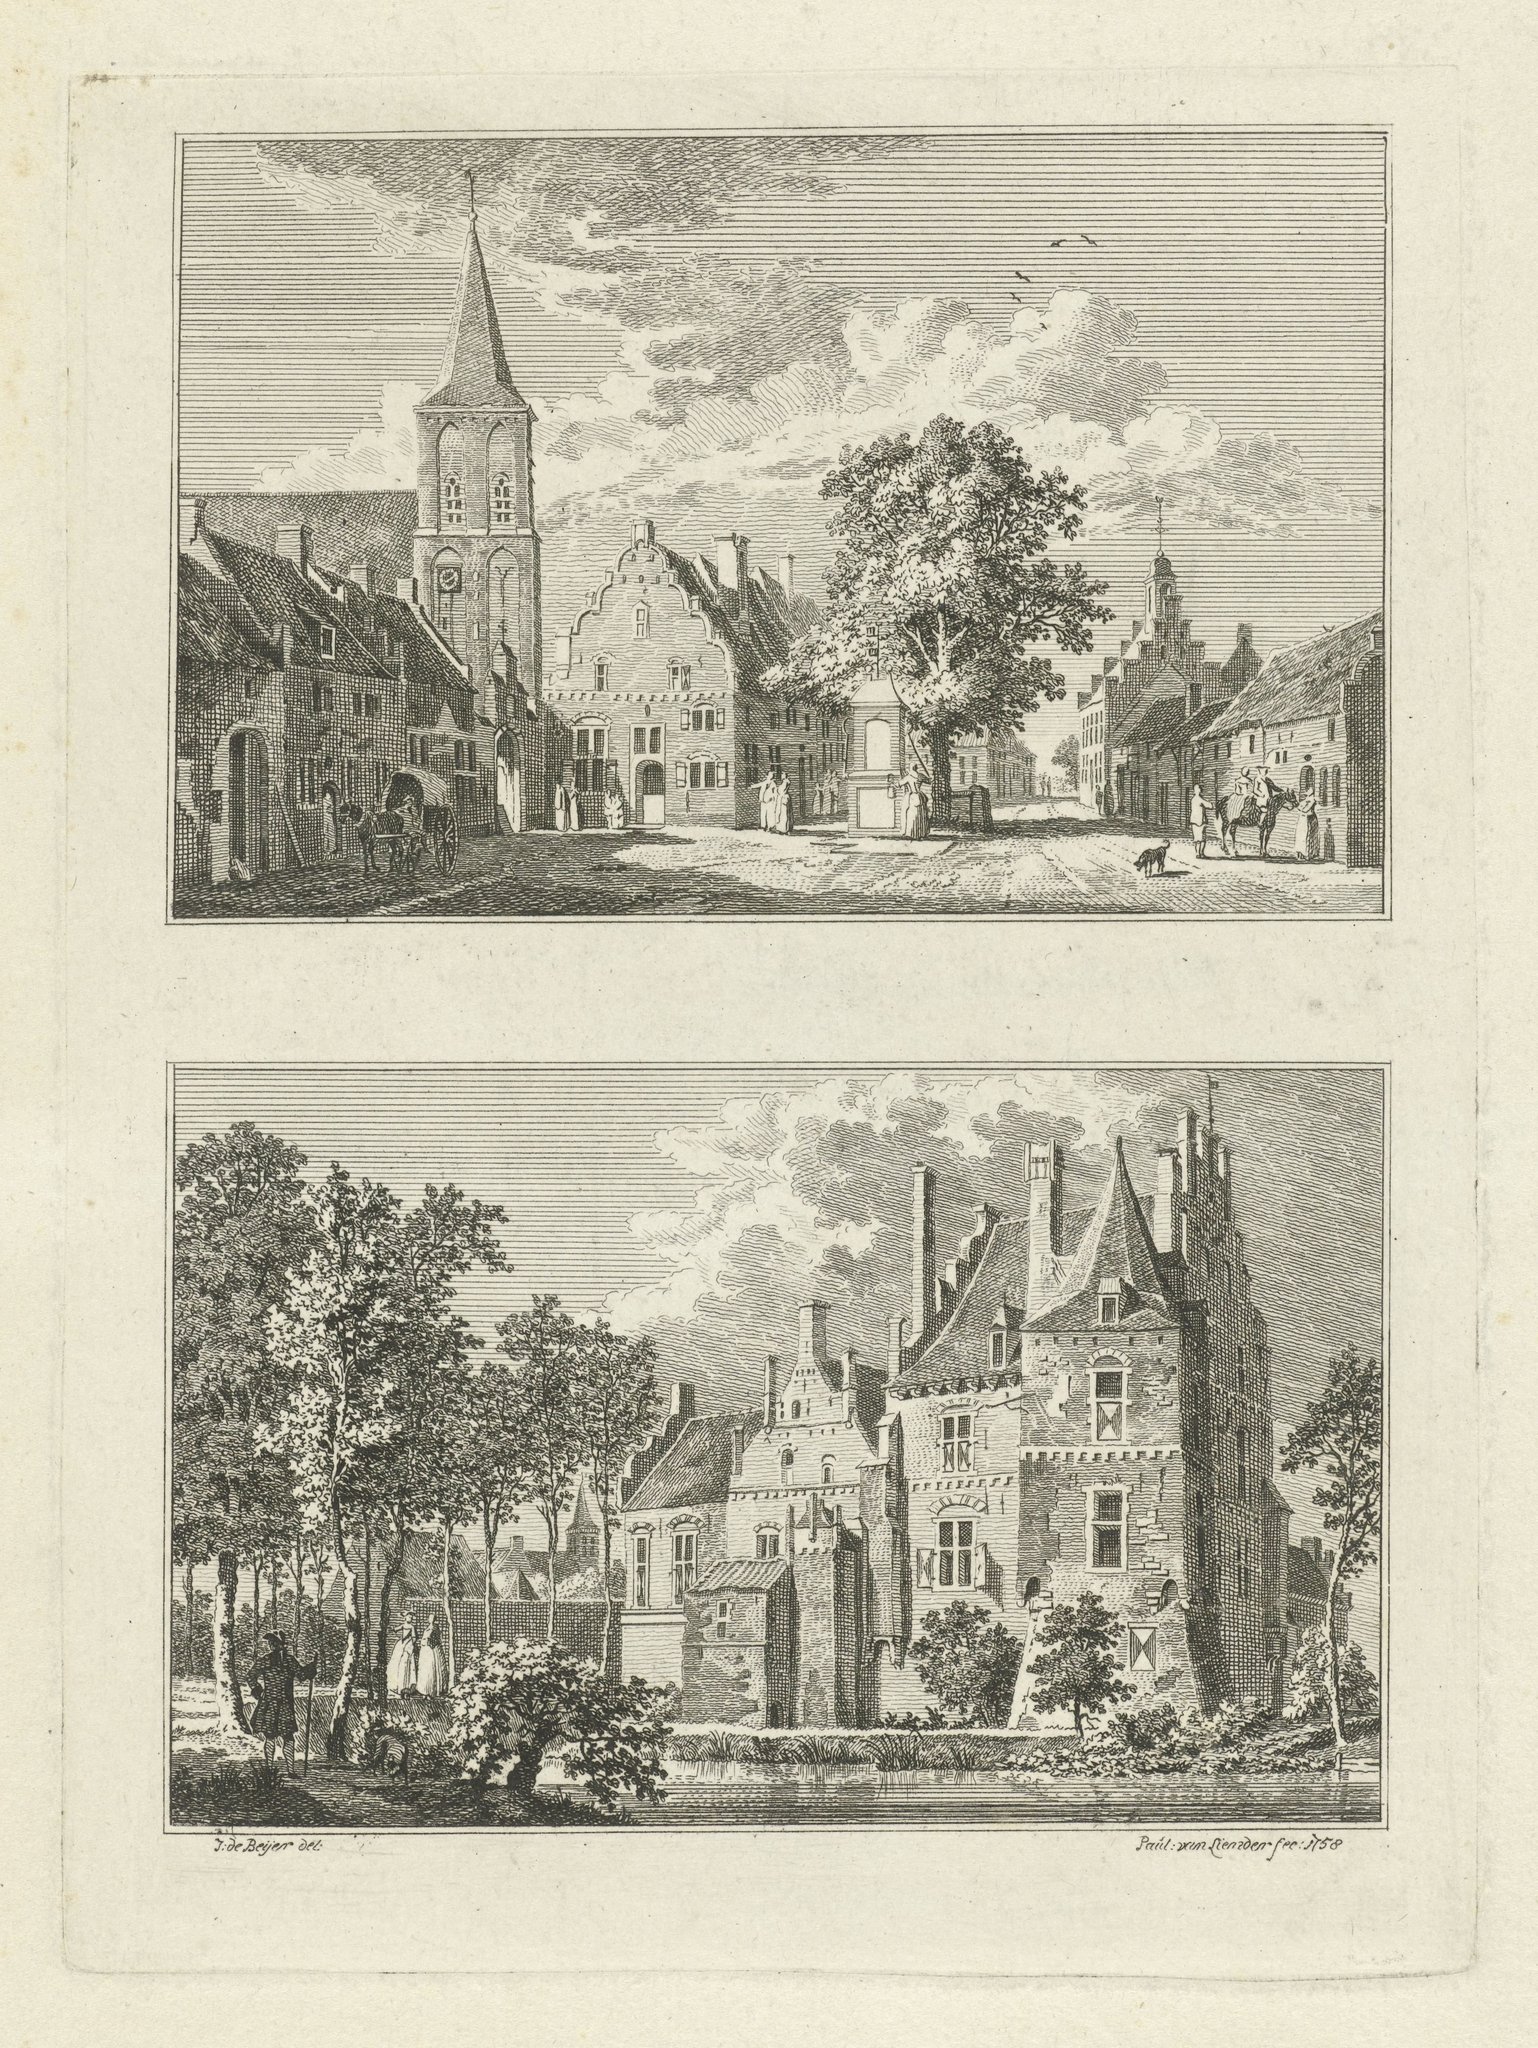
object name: print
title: Dorpsgezichten te Griethausen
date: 1758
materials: paper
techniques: etching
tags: village, church (exterior)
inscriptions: collector's mark: Lugt 2228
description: Twee voorstellingen van één plaat. Gezichten op de markt (boven) en een huis (onder) in het Duitse dorp Griethausen. De prent maakt deel uit van een 100-delige serie met gezichten op dorpen en steden te Kleef.